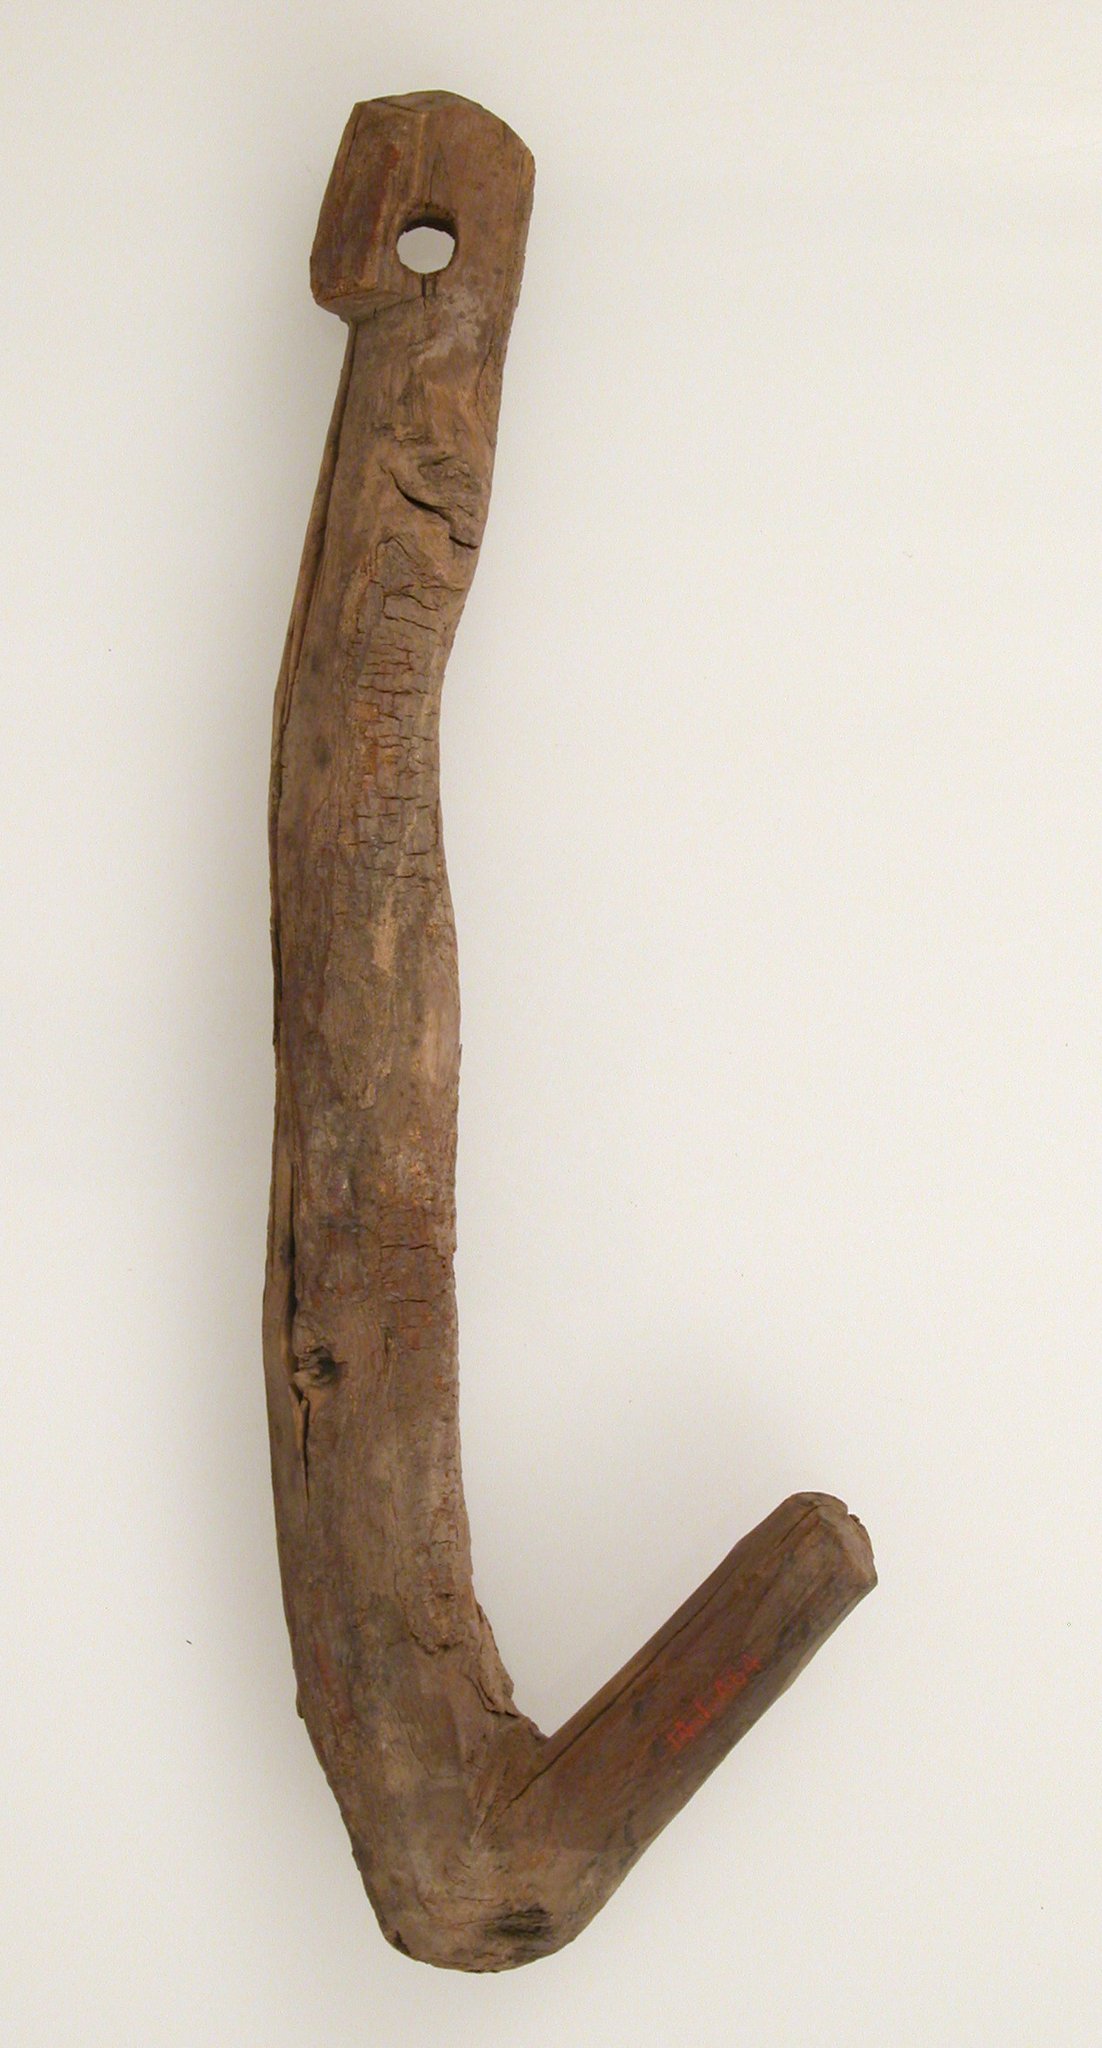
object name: hook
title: Lifting Hook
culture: coptic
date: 580-640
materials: wood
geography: egypt